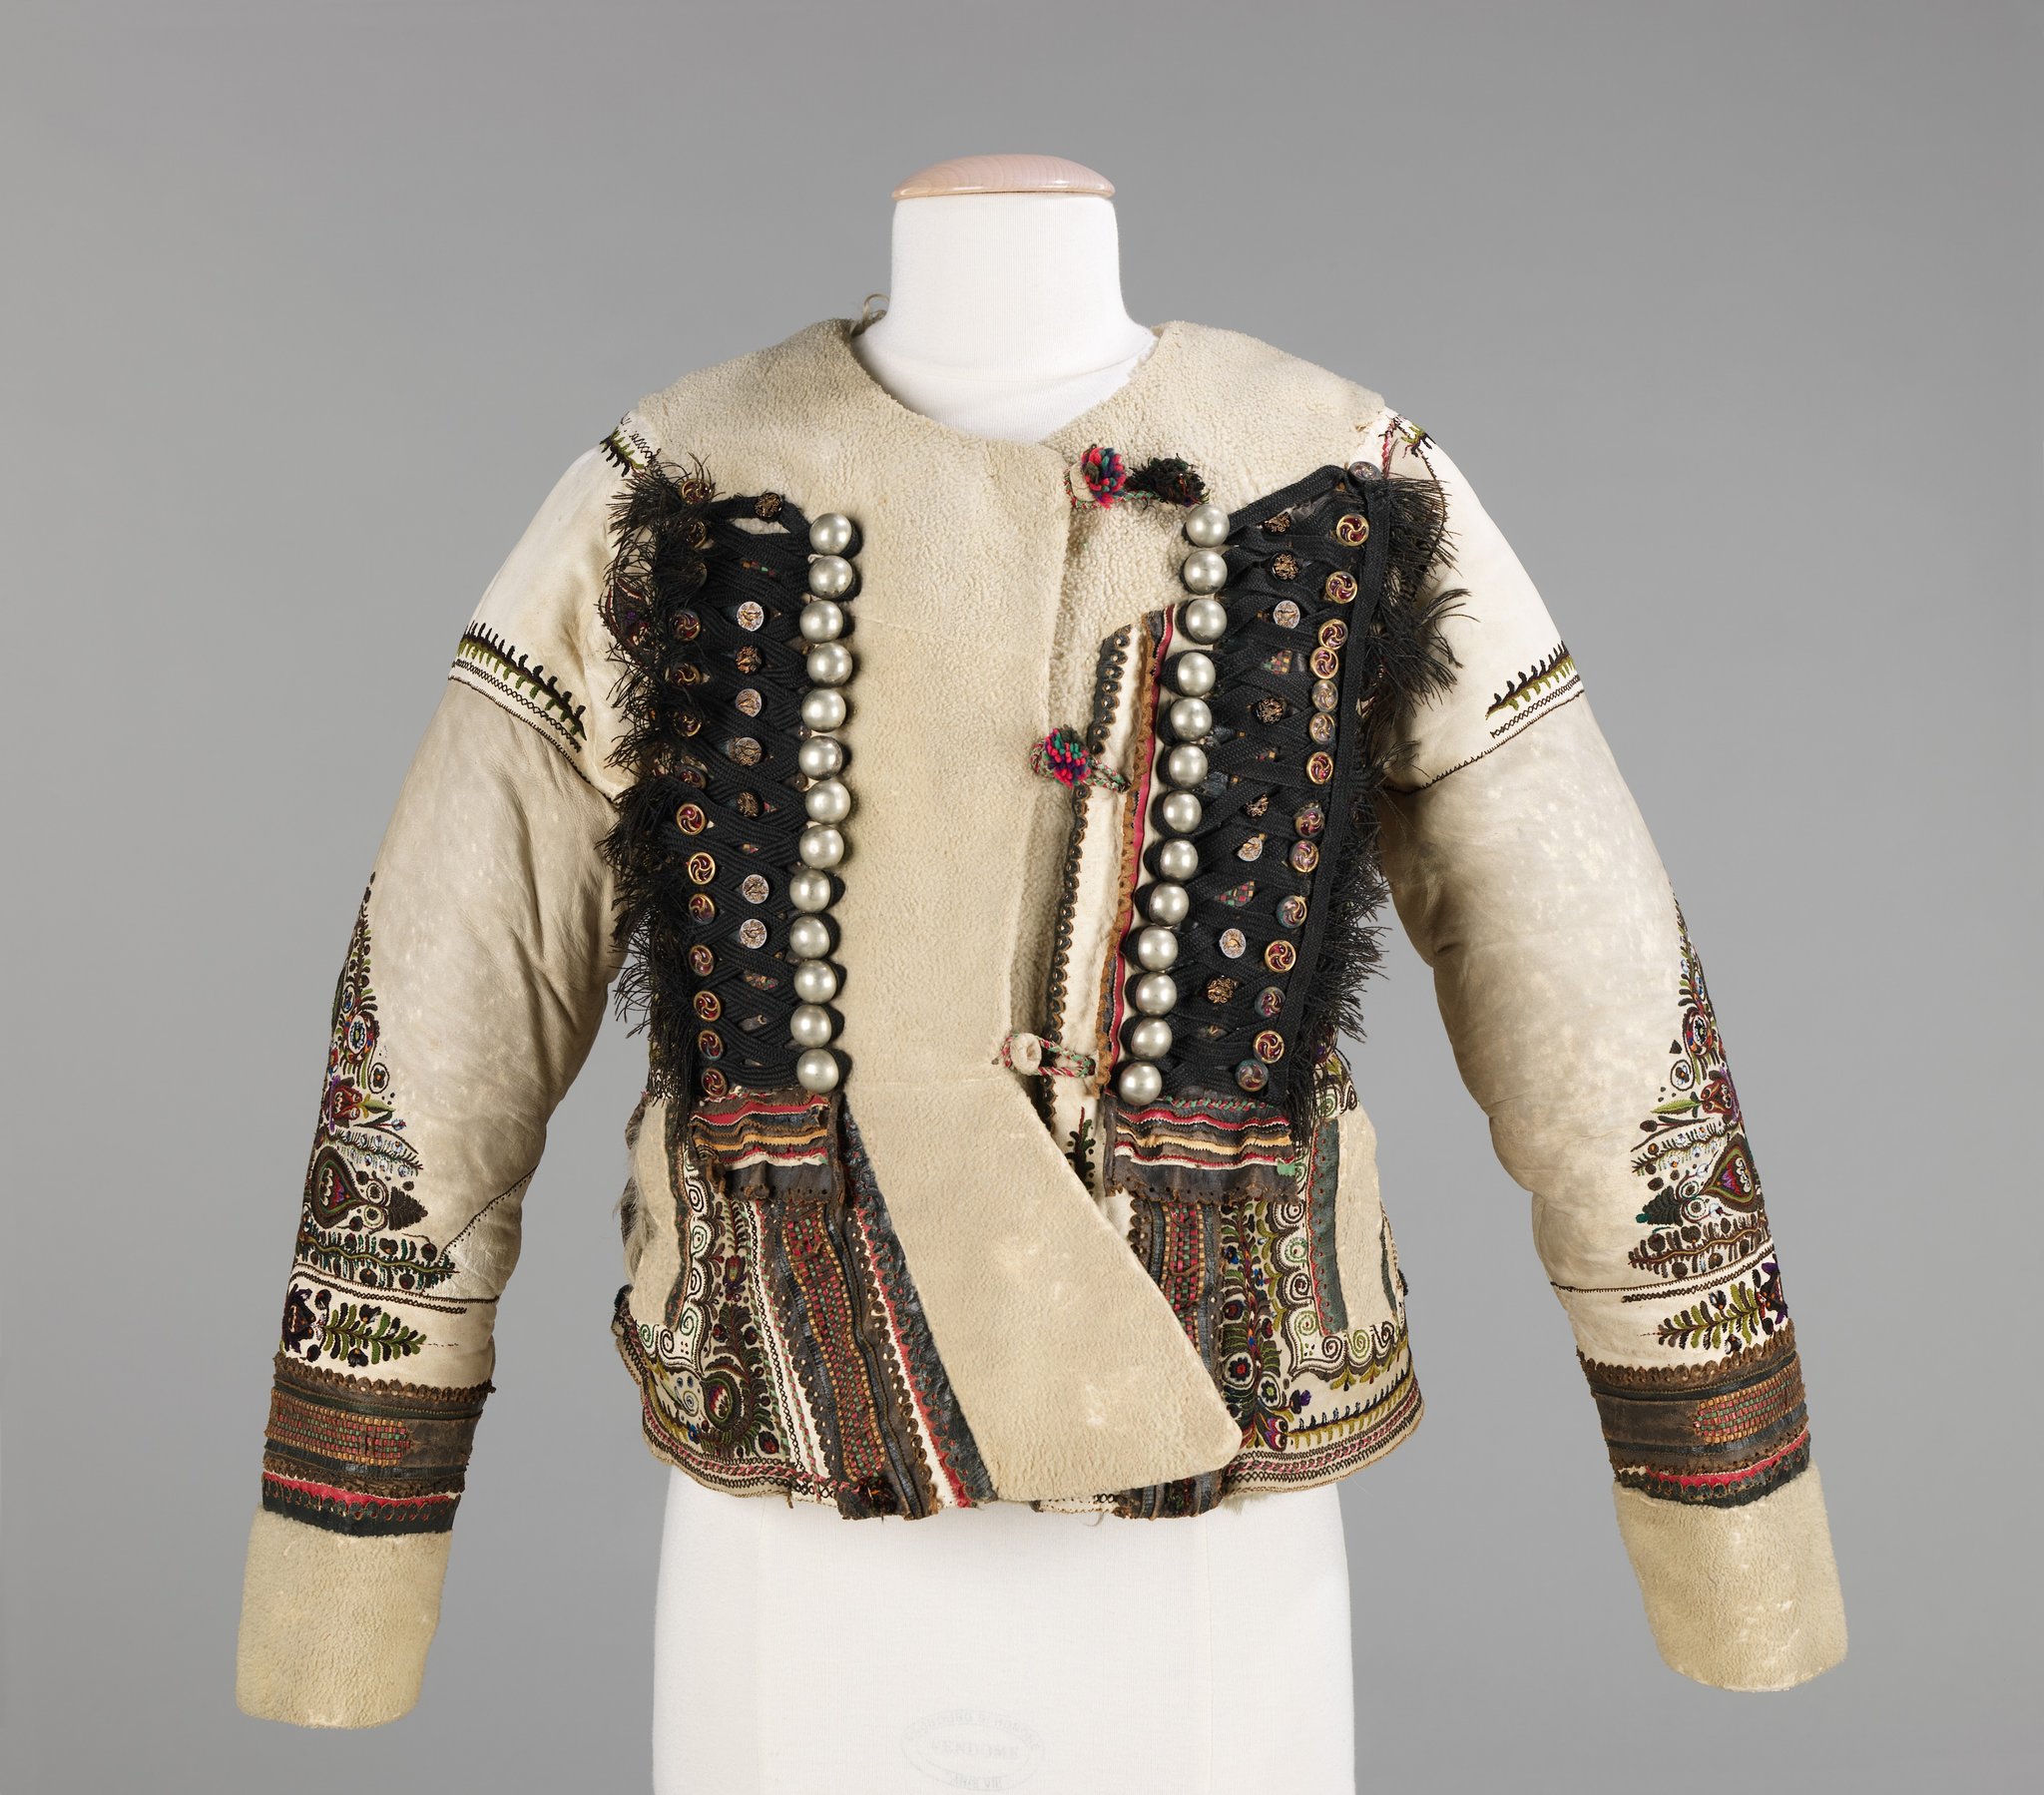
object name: jacket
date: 1867-1900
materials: glass, leather, metal, silk, wool